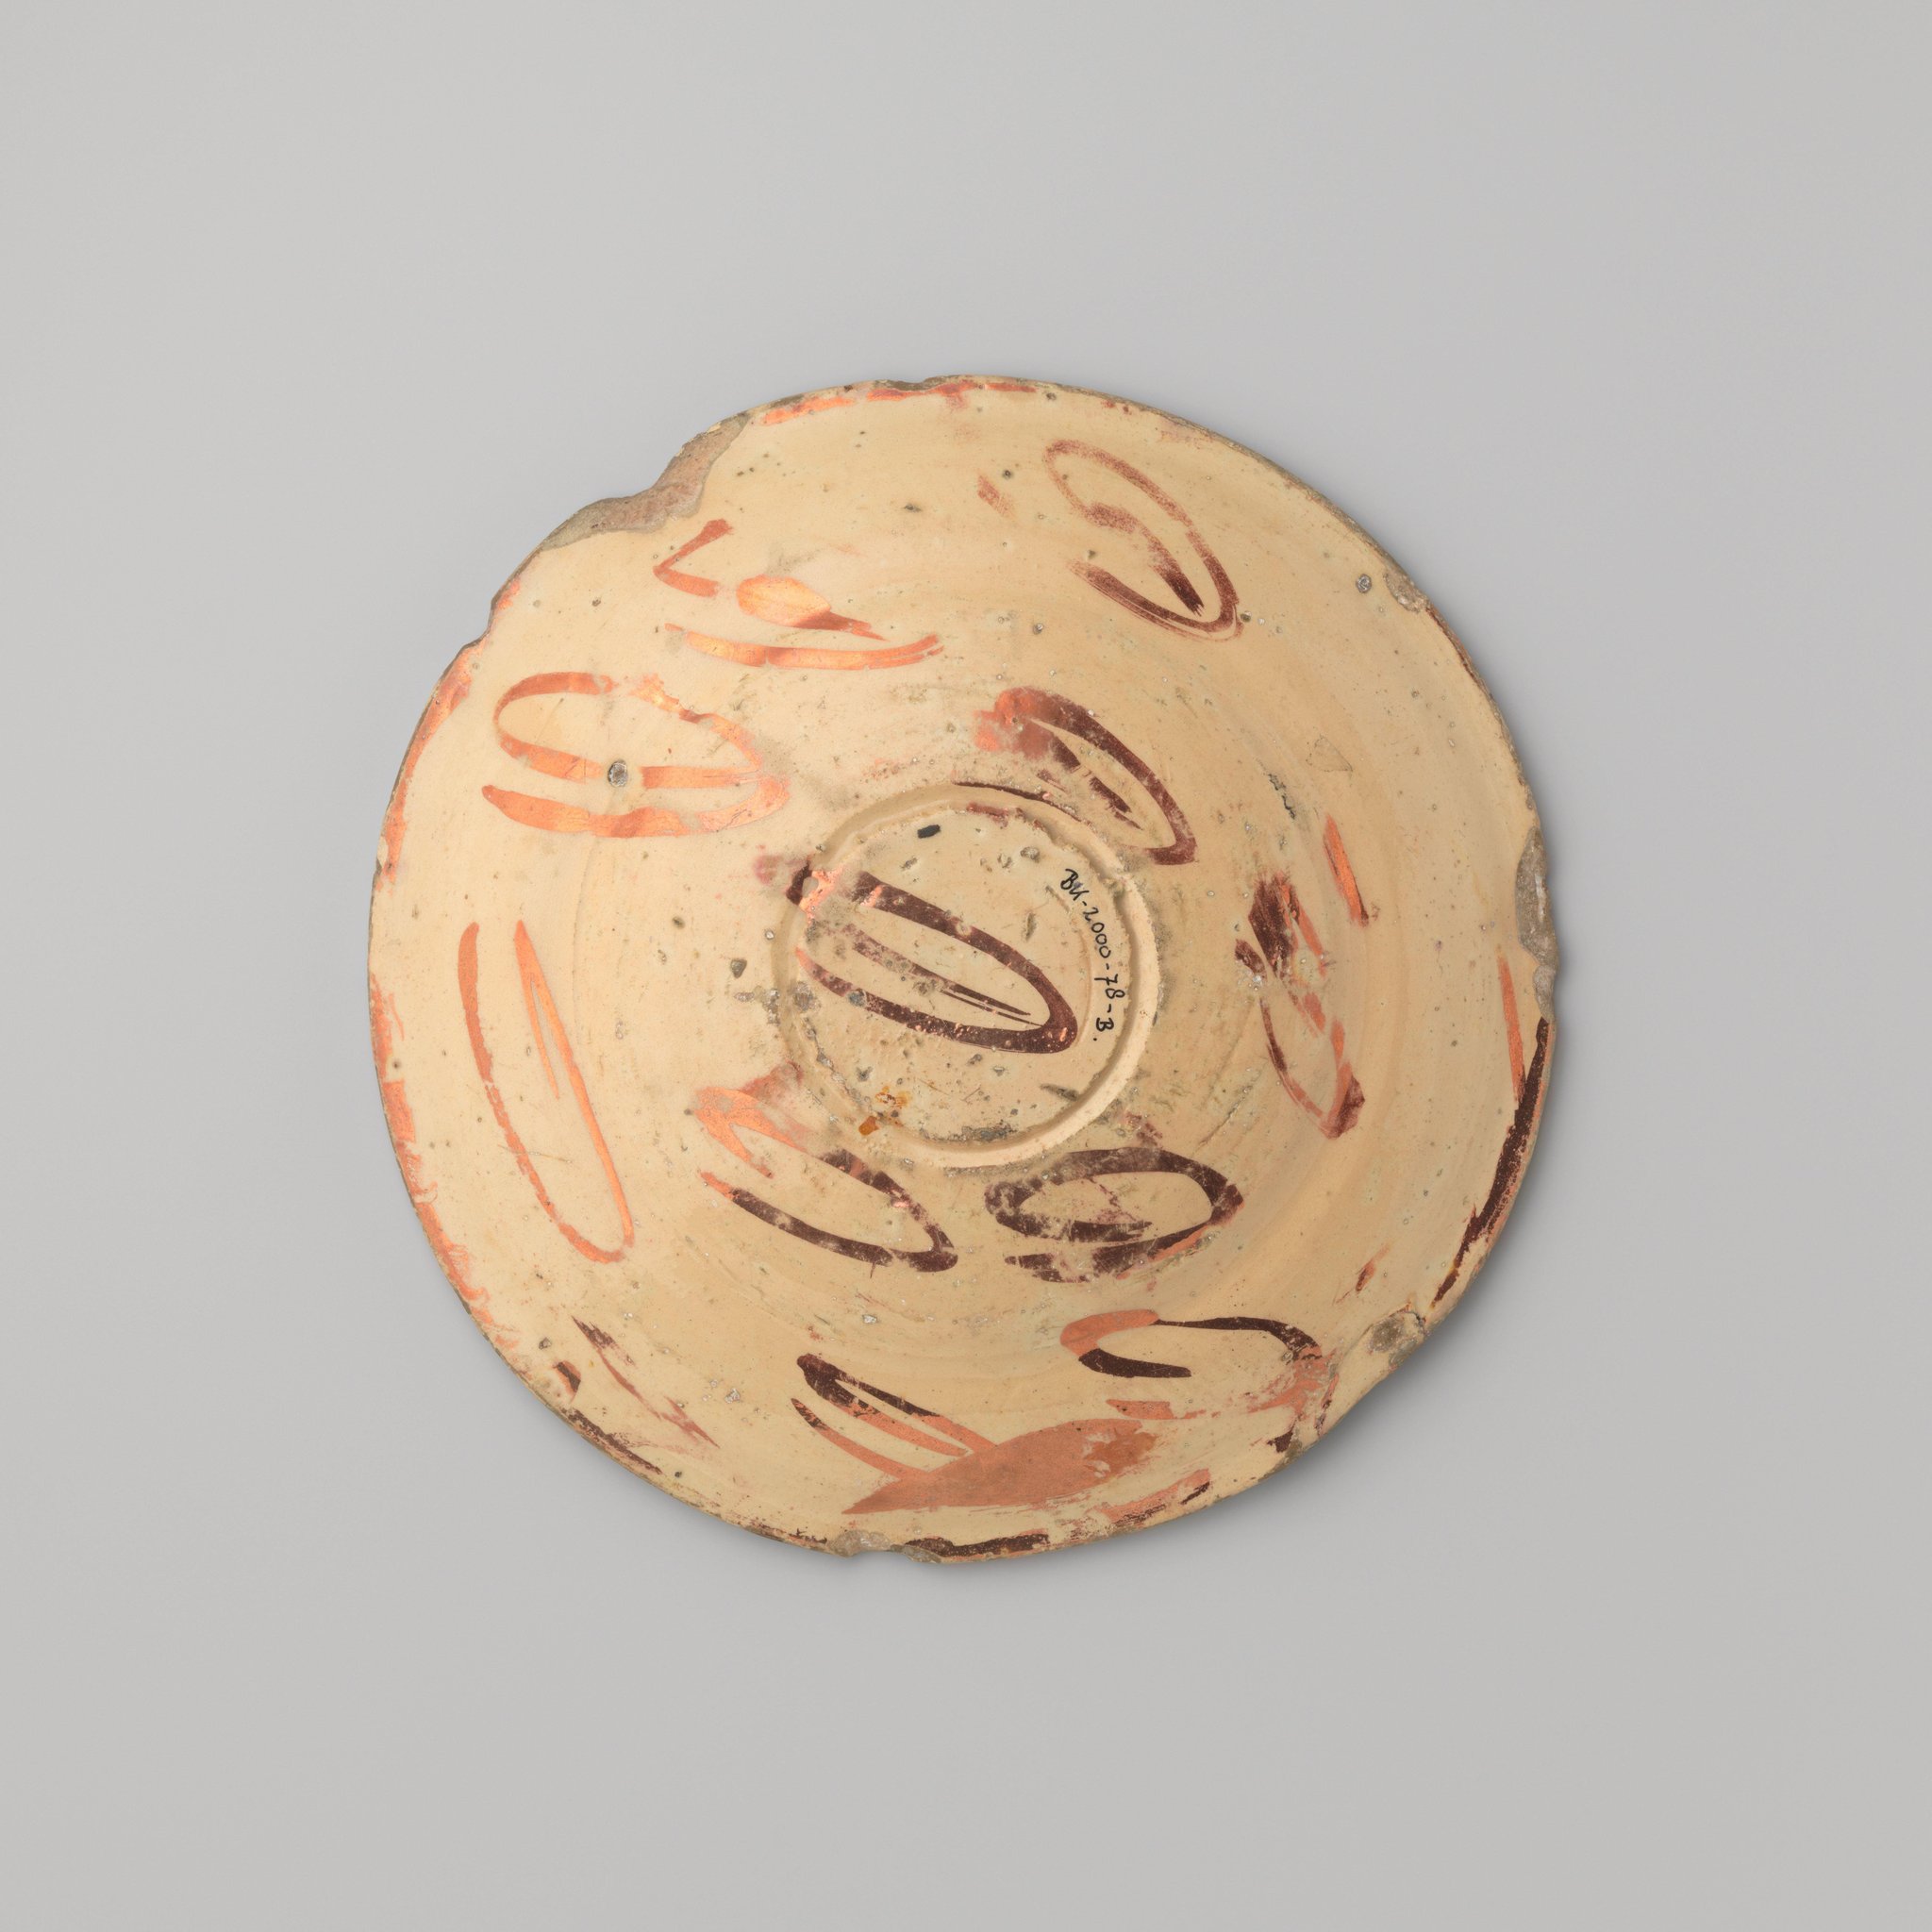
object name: plate dish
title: Bord van majolica met beschildering in lustertechniek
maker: Anonymous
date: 1600-1699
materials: earthenware, glaze, luster, paint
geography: spain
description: Bord van majolica met beschildering in lustertechniek.